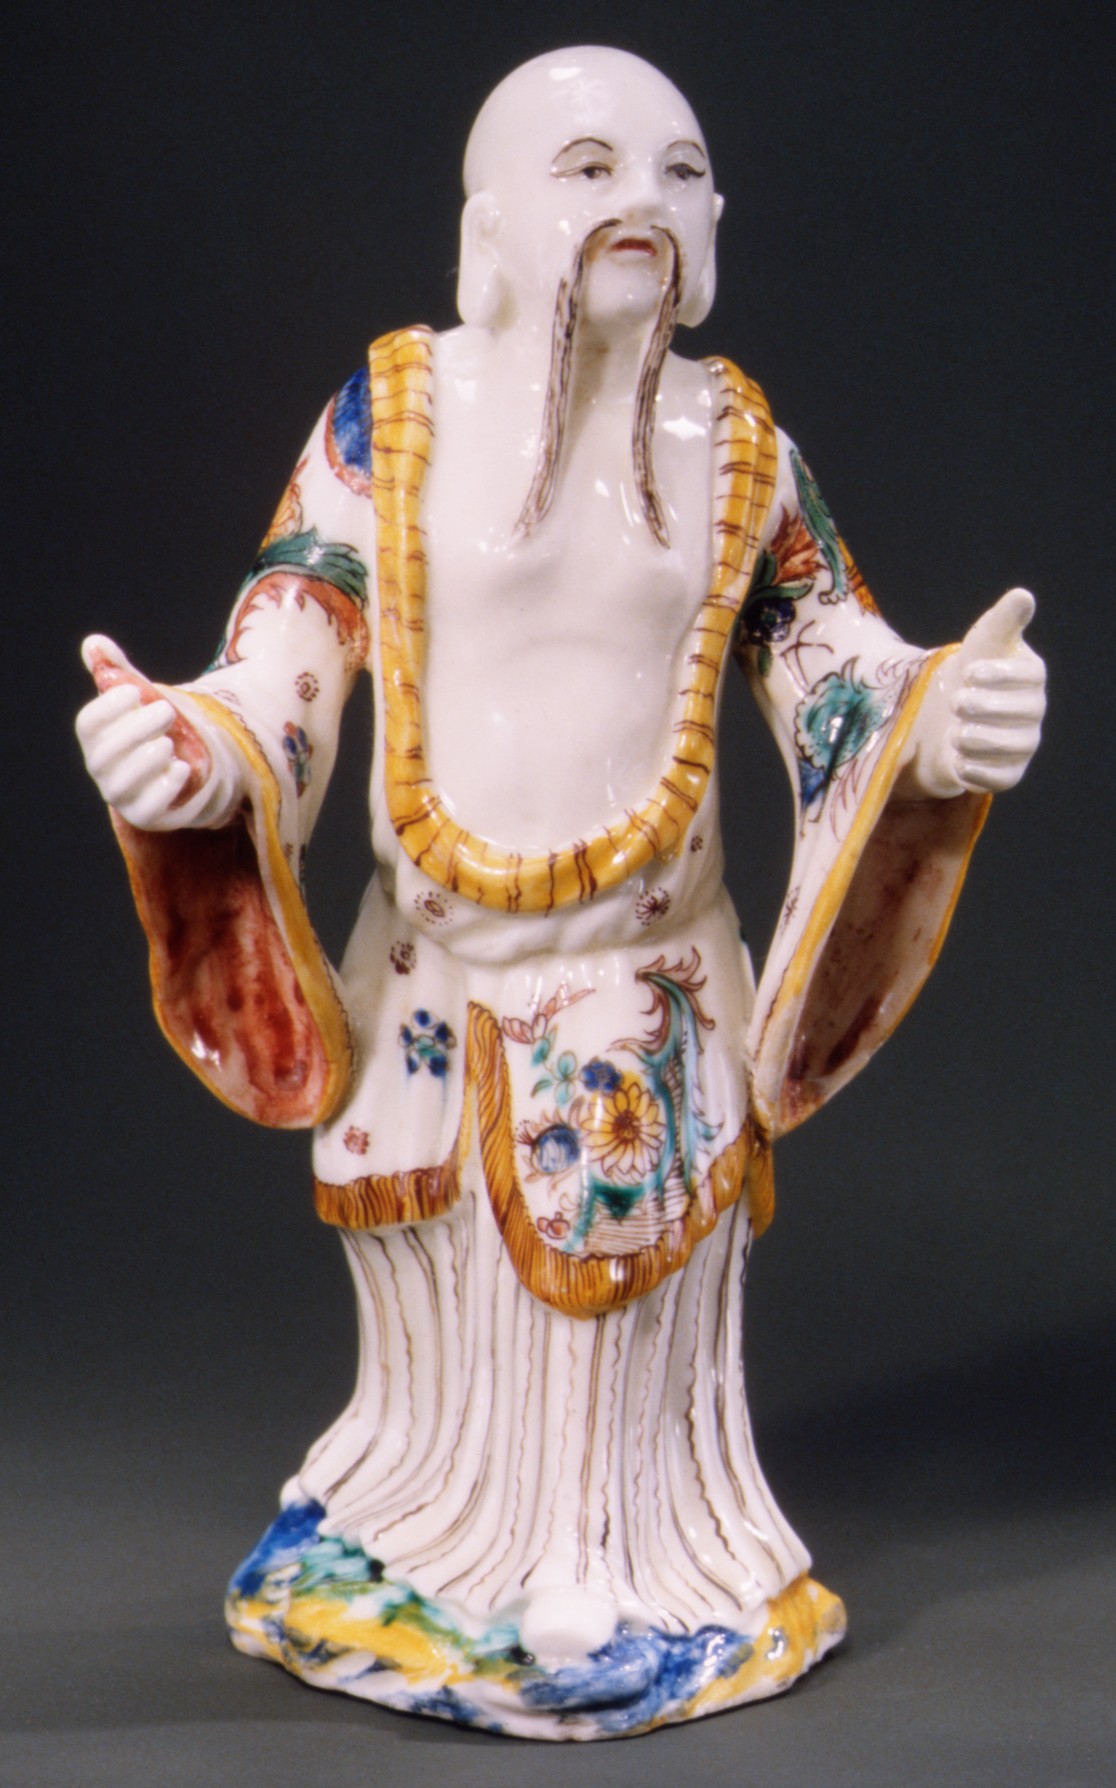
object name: figure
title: Figure of a standing Chinese man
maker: villeroy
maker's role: factory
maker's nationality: french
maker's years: 1734-1748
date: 1740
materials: soft paste porcelain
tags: men